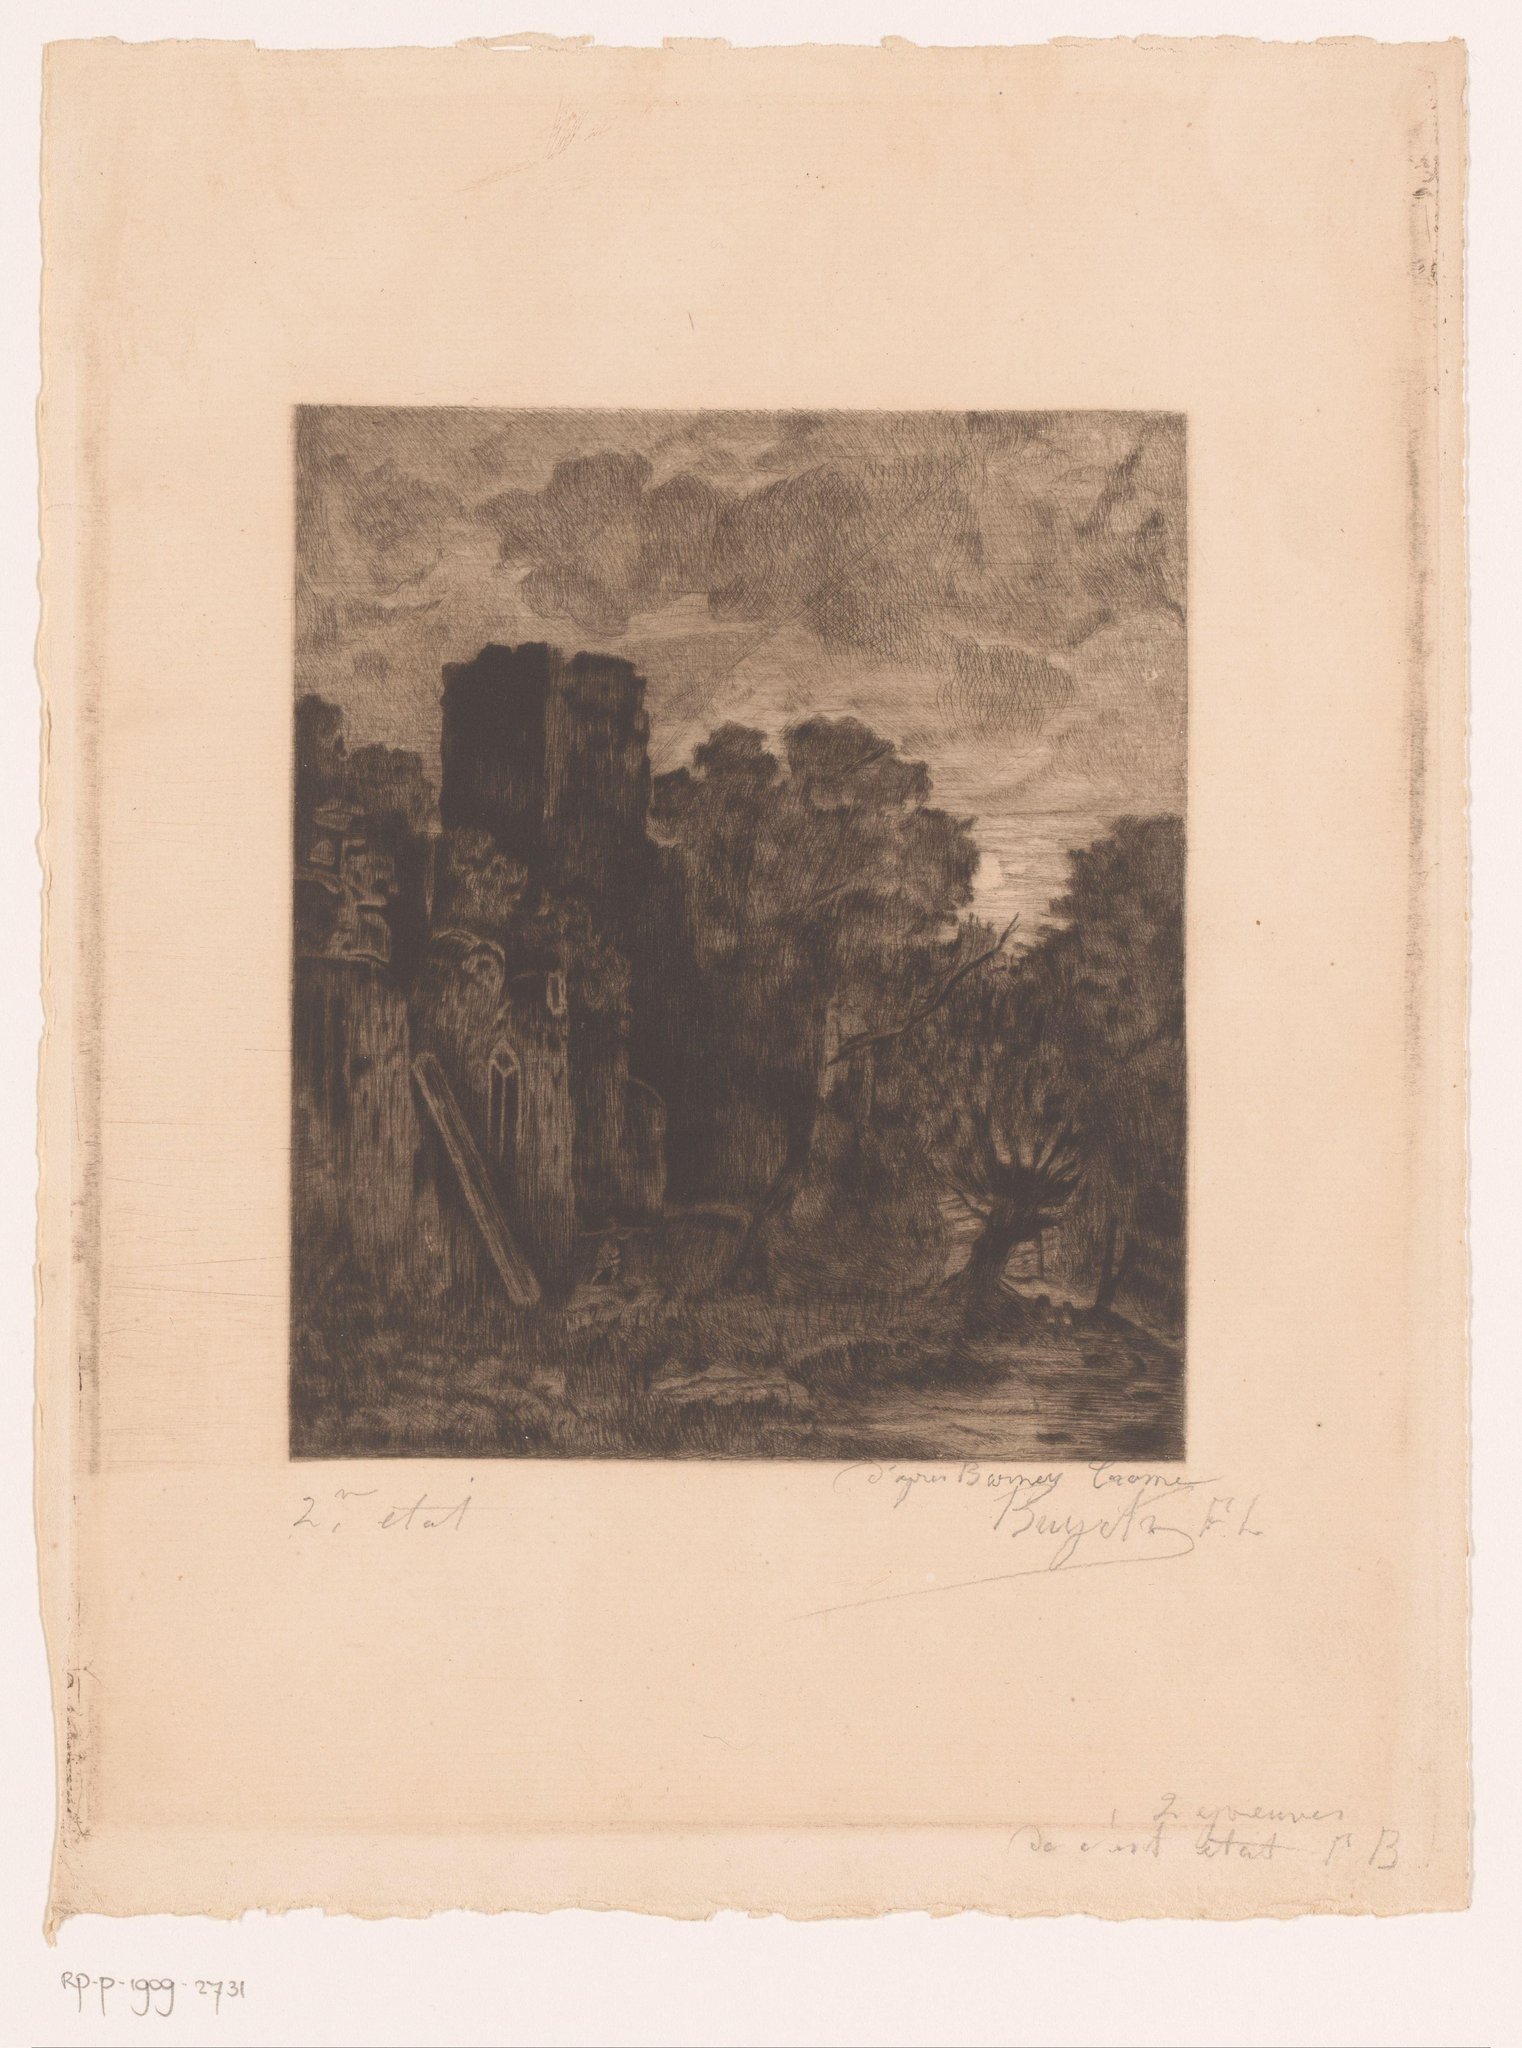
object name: print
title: Landschap met kasteelruïne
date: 1870-1909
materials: paper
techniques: etching, intaglio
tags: ruin of a dwelling, house, castle, etc.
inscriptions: collector's mark: Lugt 2228, annotation: ‘2 epreuves de c'est etat’, annotation: ‘2me etat’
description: Sterfdatum prentmaker onbekend. Derhalve is voor bepaling van de rechten van dit object de verwervingsdatum aangehouden.